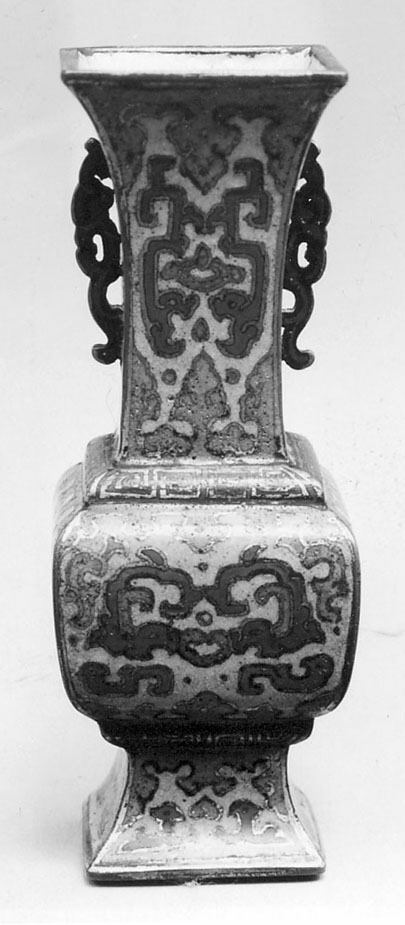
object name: vase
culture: chinese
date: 1662-1722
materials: copper, enamel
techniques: enamel